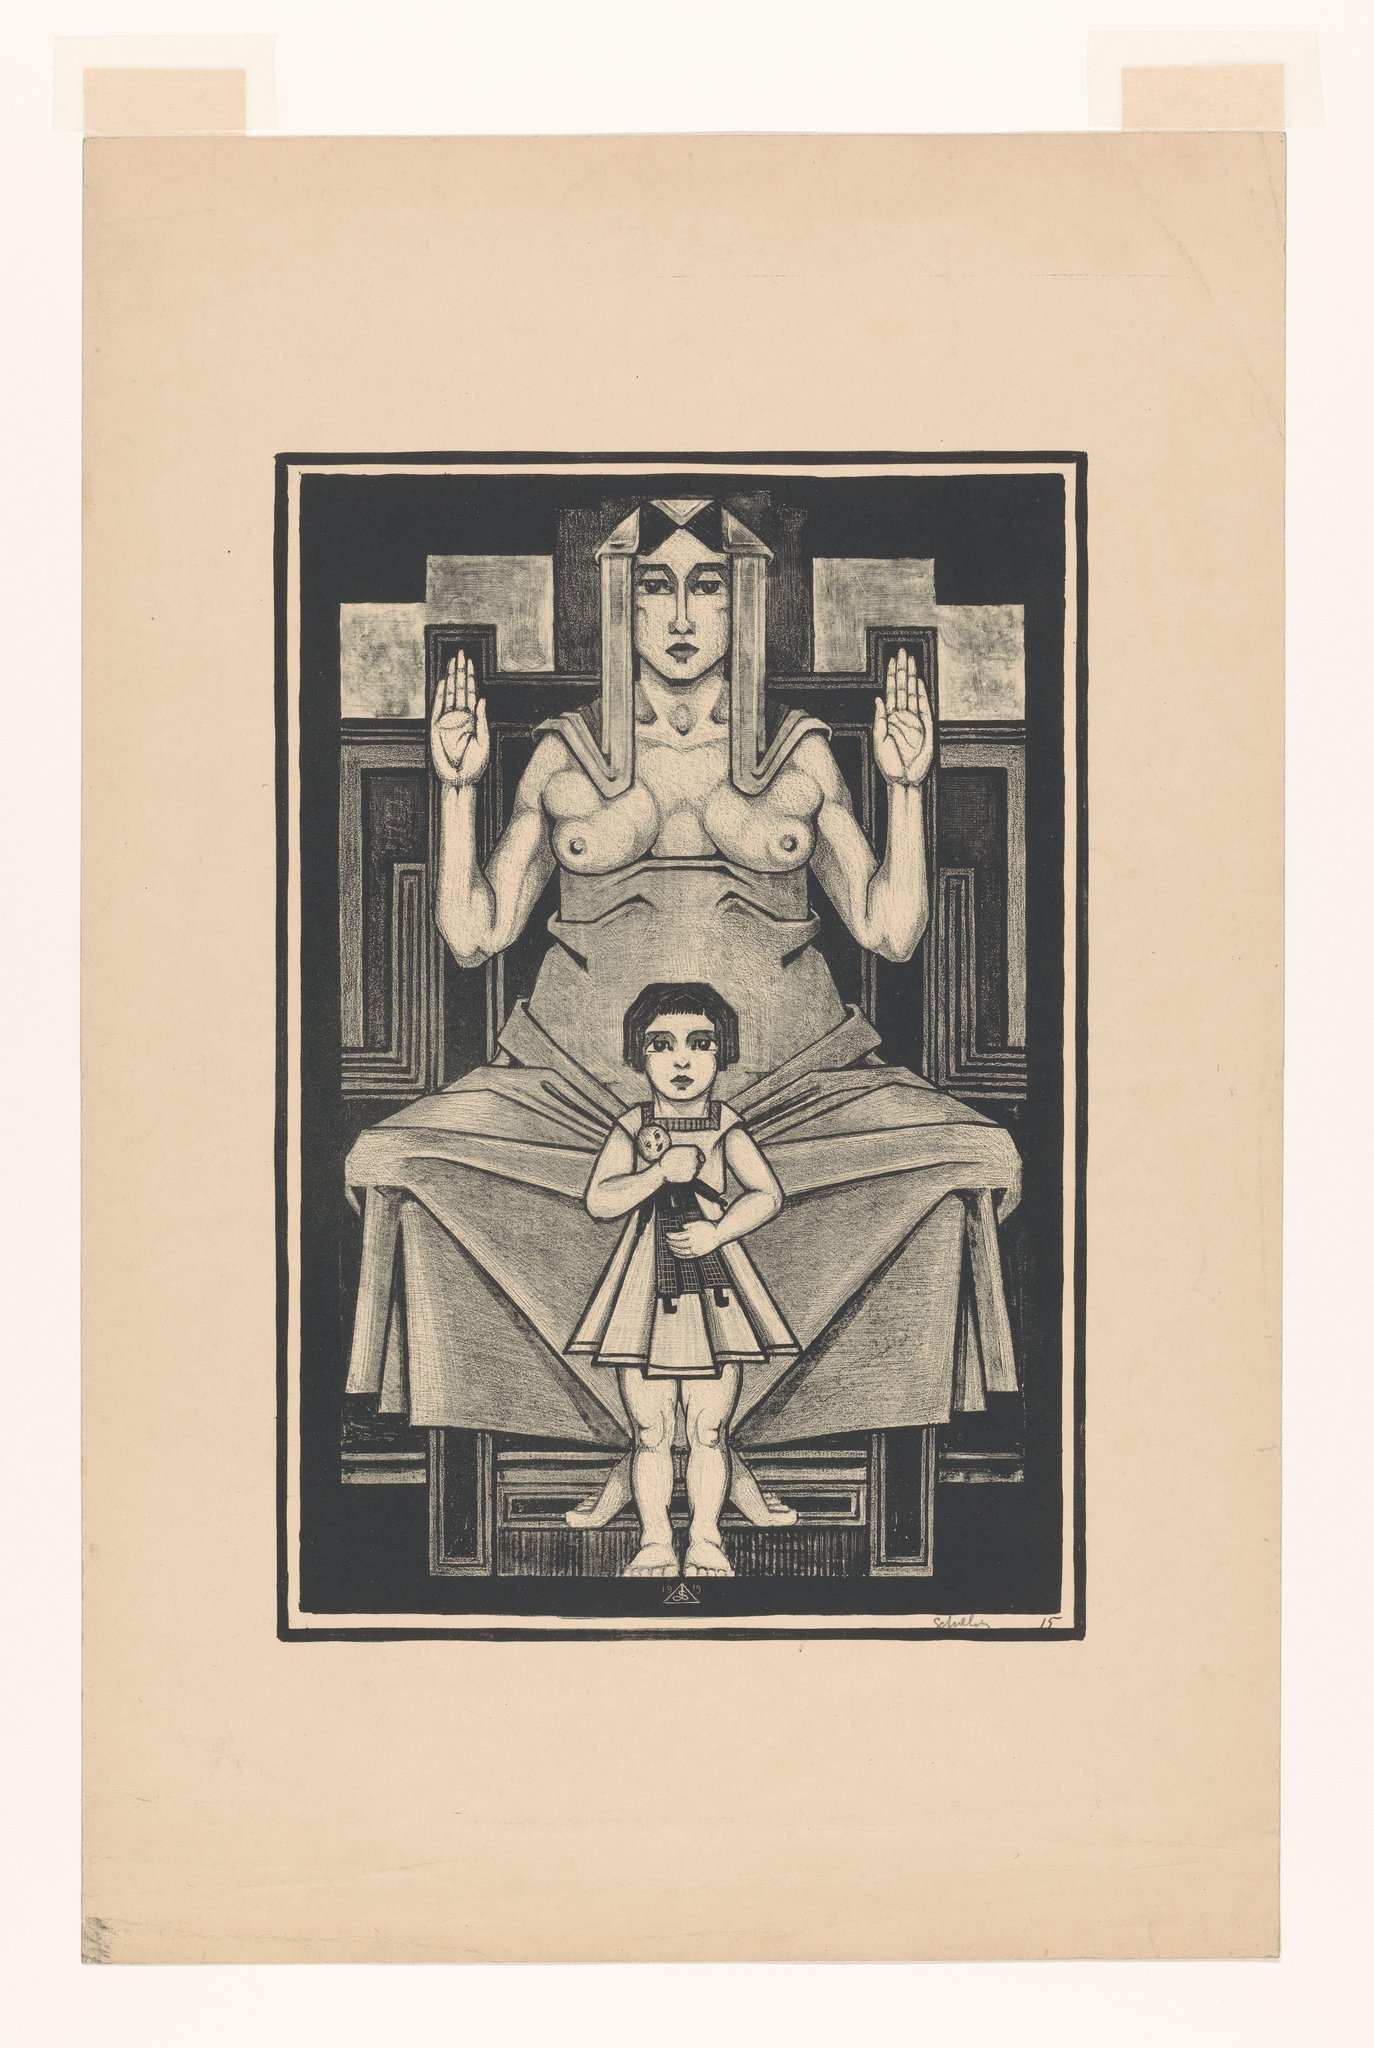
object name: print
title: Symbolische voorstelling: moederschap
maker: henk schilling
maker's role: print maker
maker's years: 1893-1942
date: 1919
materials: paper, ink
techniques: lithograph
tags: motherhood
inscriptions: monogram and date: ‘S 1919’, signature: ‘Schilling’, number: ‘15’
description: De huidige titel is door het Rijksmuseum overgenomen van het Instituut Collectie Nederland.